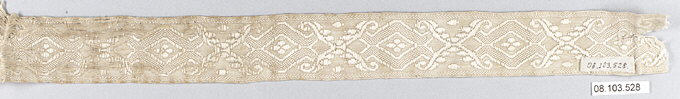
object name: galloon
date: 1701-1900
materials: silk